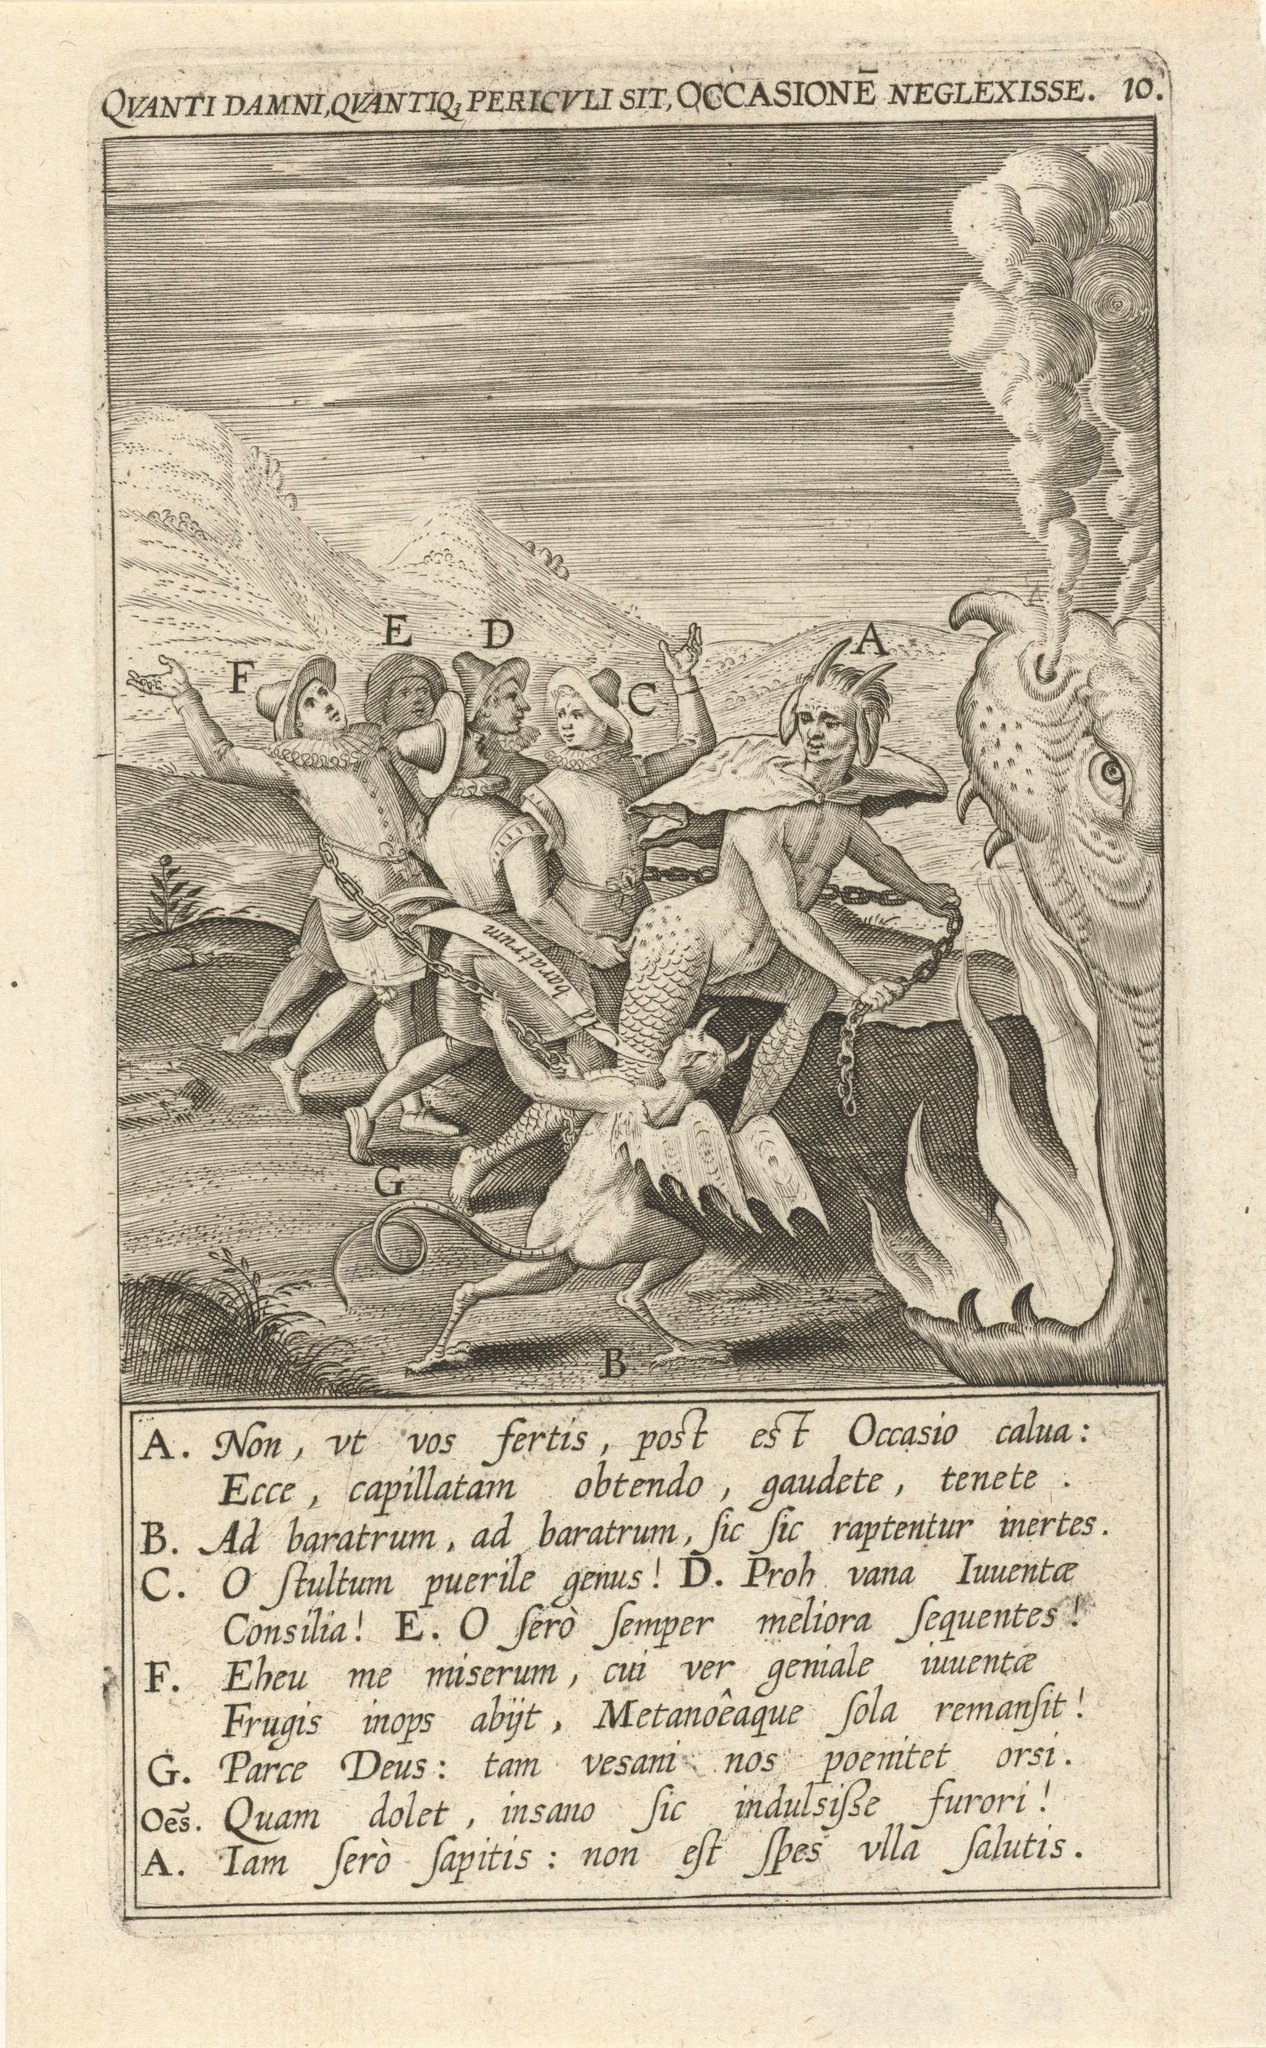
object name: print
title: Typus occasionis in quo receptae commoda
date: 1603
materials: paper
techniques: engraving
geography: antwerp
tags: youth, adolescent, devil or demons attacking mortals, (person) in fetters, not imprisoned, entrance of hell as monstrous mouth (of leviathan), man as sinner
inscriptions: collector's mark: Lugt 2228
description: De vijf zondige jongeren worden geketend door twee duivels afgevoerd richting de hellemond. De prent heeft een Latijns onderschrift met legende en maakt deel uit van een 12-delige serie over het benutten van kansen.